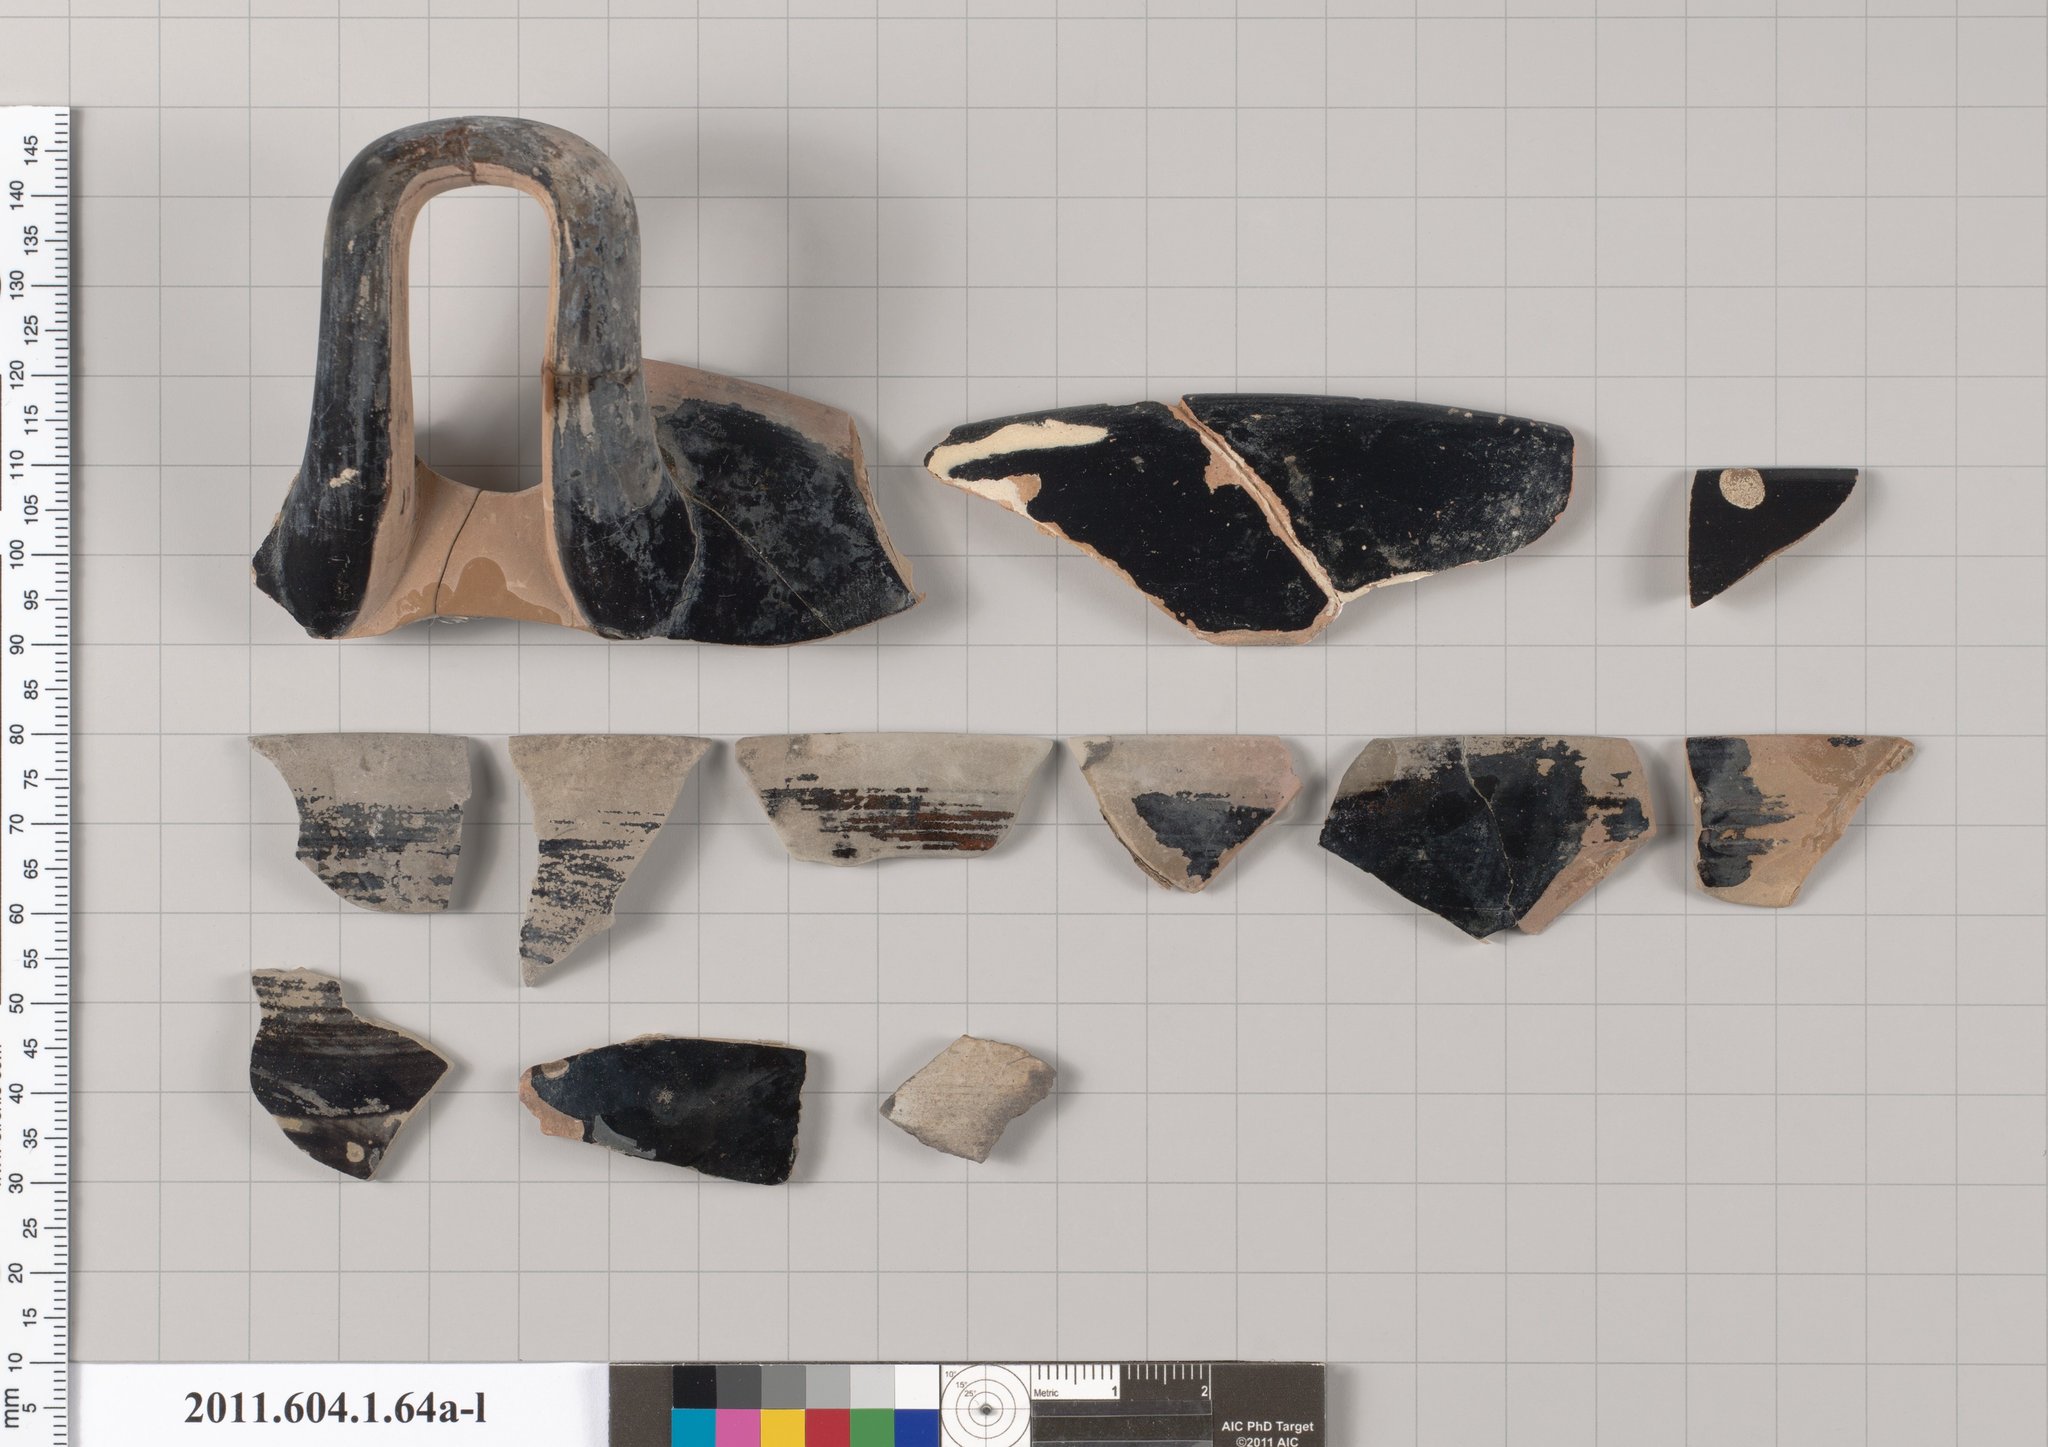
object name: kylix fragment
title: Terracotta fragments of a kylix (drinking cup)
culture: greek, attic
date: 500-401 BCE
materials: terracotta